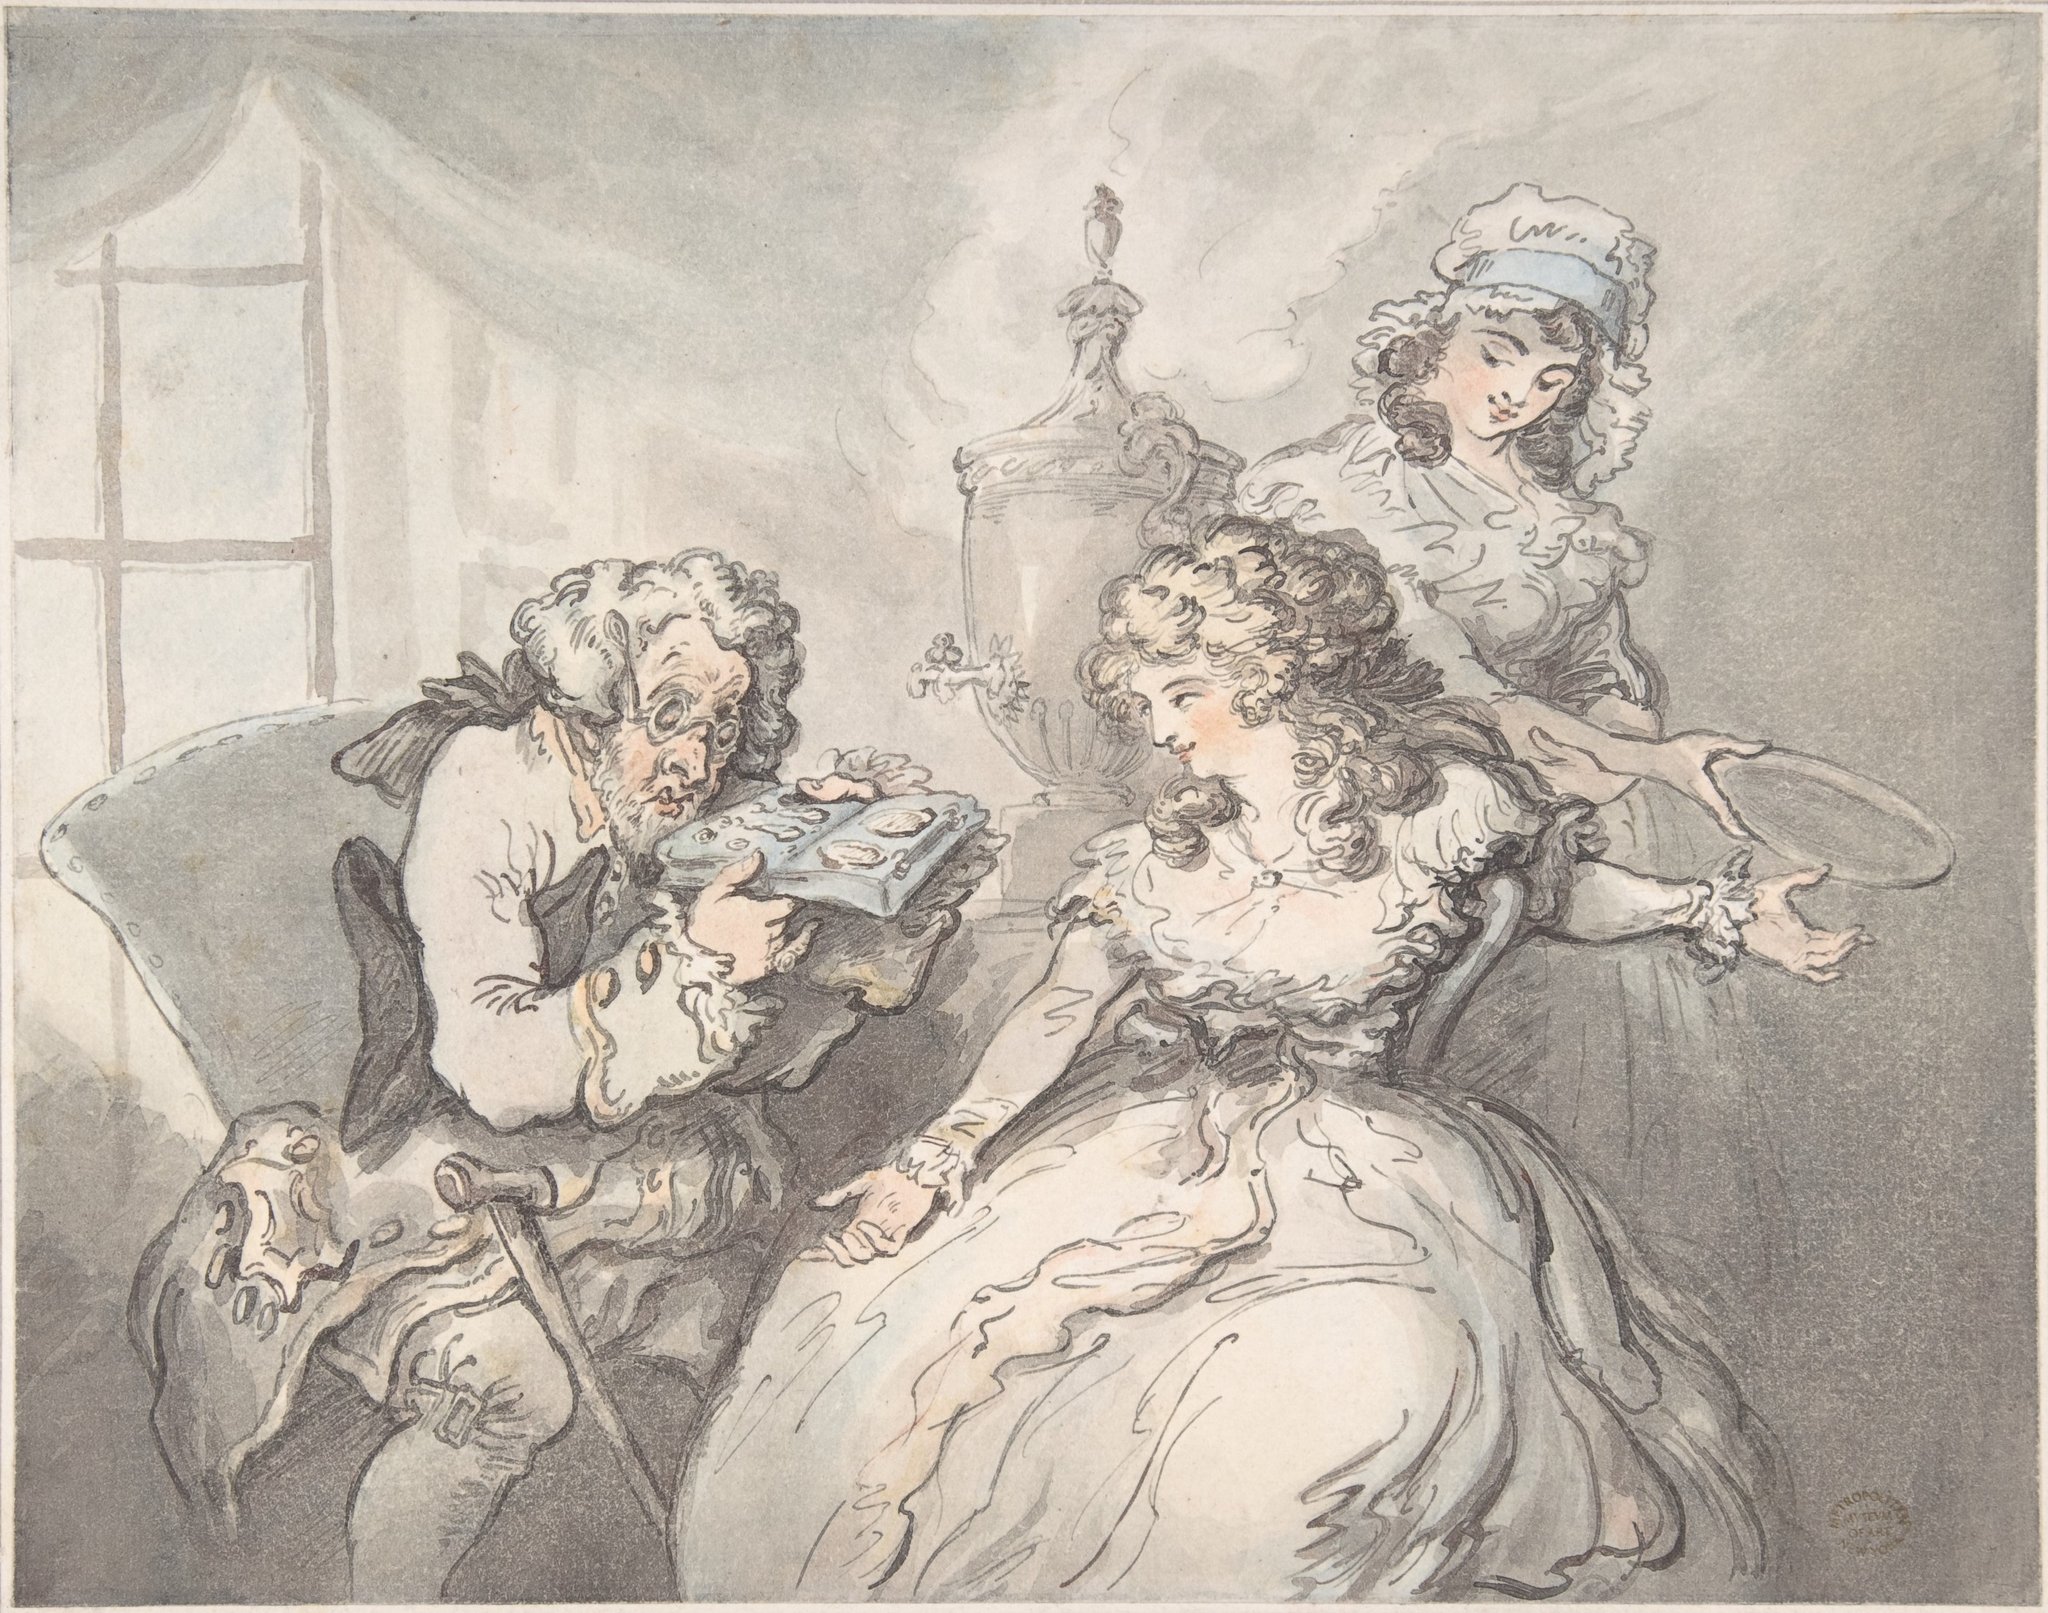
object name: drawing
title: The Connoisseur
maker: thomas rowlandson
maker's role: artist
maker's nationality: british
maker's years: 1757-1827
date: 1780-1800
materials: ink, watercolor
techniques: brush, pen, wash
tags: men,women